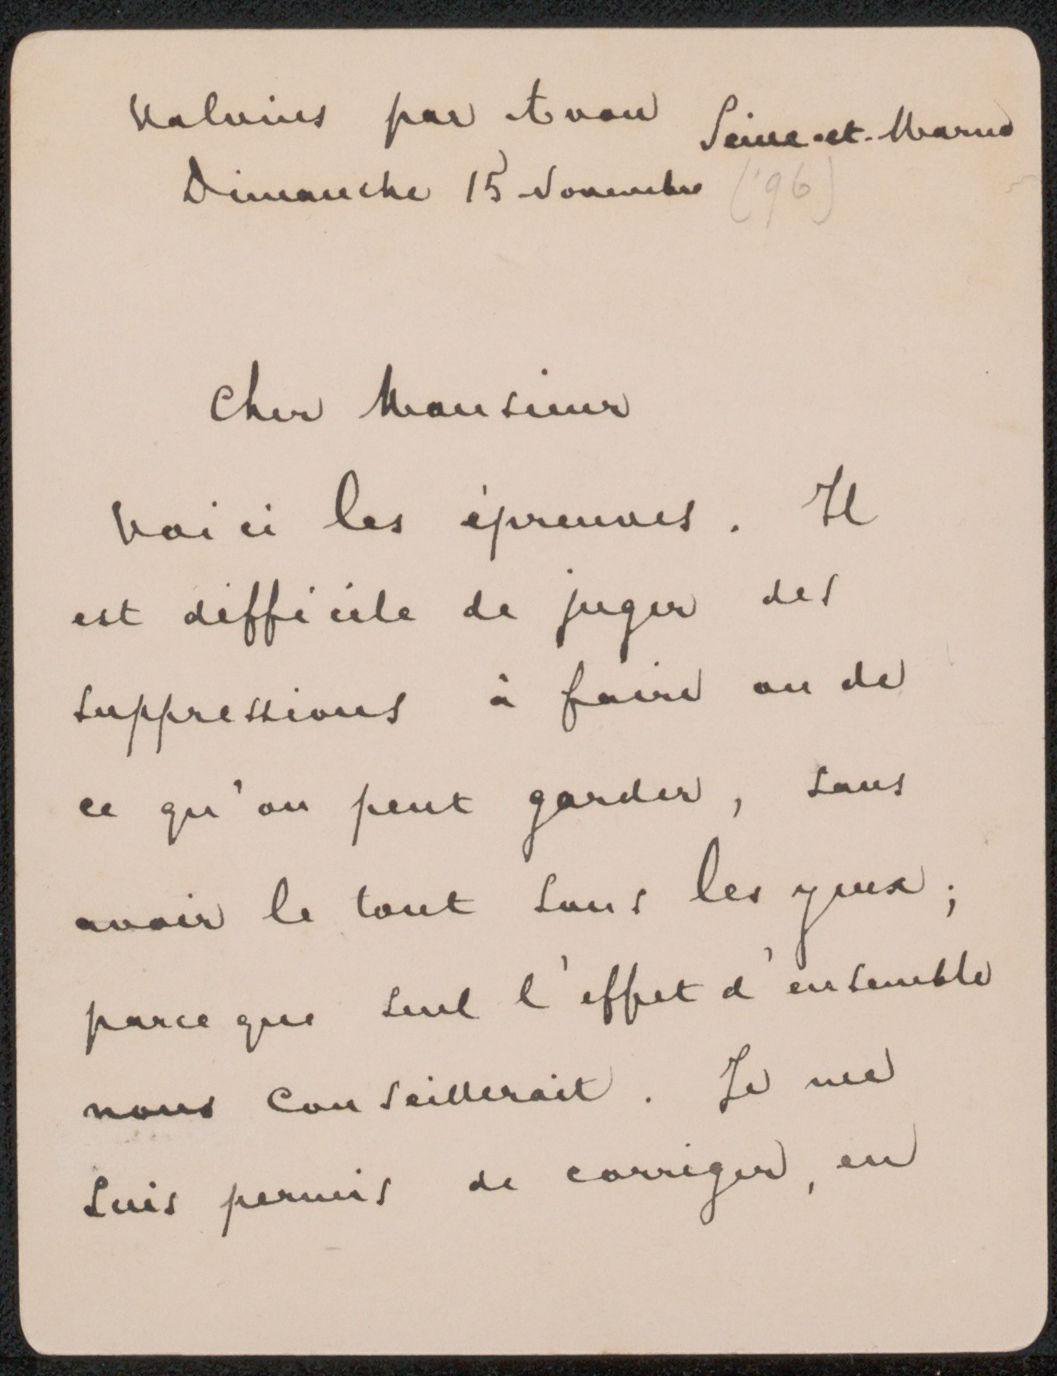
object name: letter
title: Brief aan Philip Zilcken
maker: stéphane mallarmé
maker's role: dichter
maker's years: 1842-1898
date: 1896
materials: cardboard, ink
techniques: pen, writing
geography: valvins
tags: paris, paul verlaine, painter, draughtsman, philip zilcken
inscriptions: collector's mark: ‘RPK’